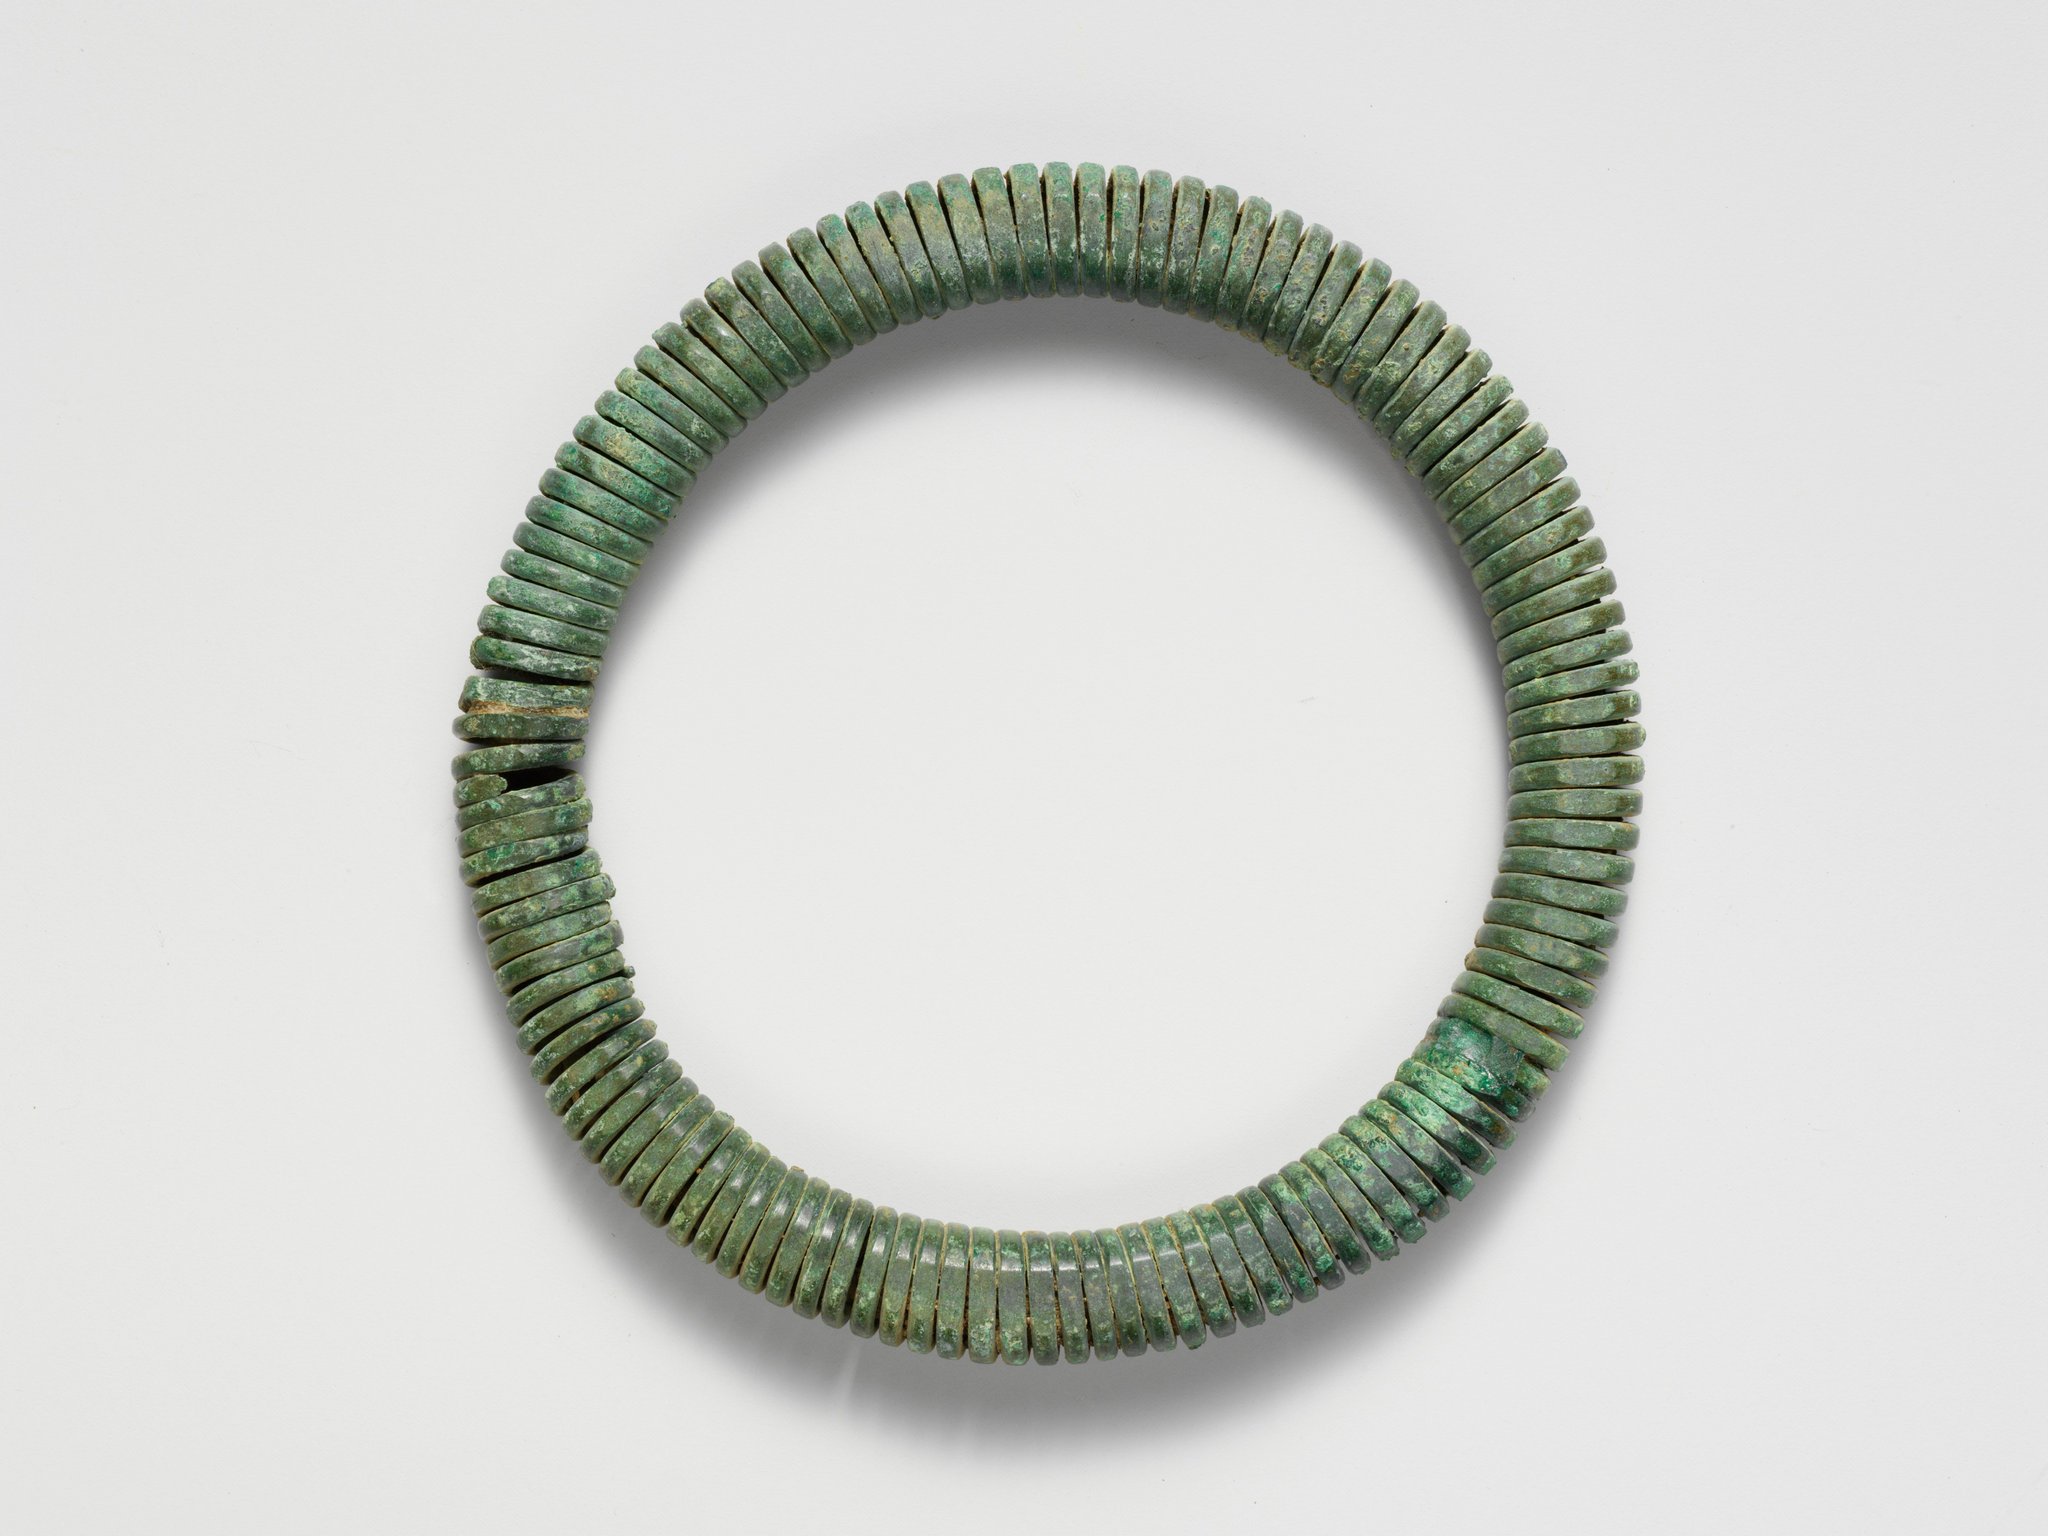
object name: bracelet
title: Bronze twisted-wire bracelet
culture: italic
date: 900-701 BCE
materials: bronze